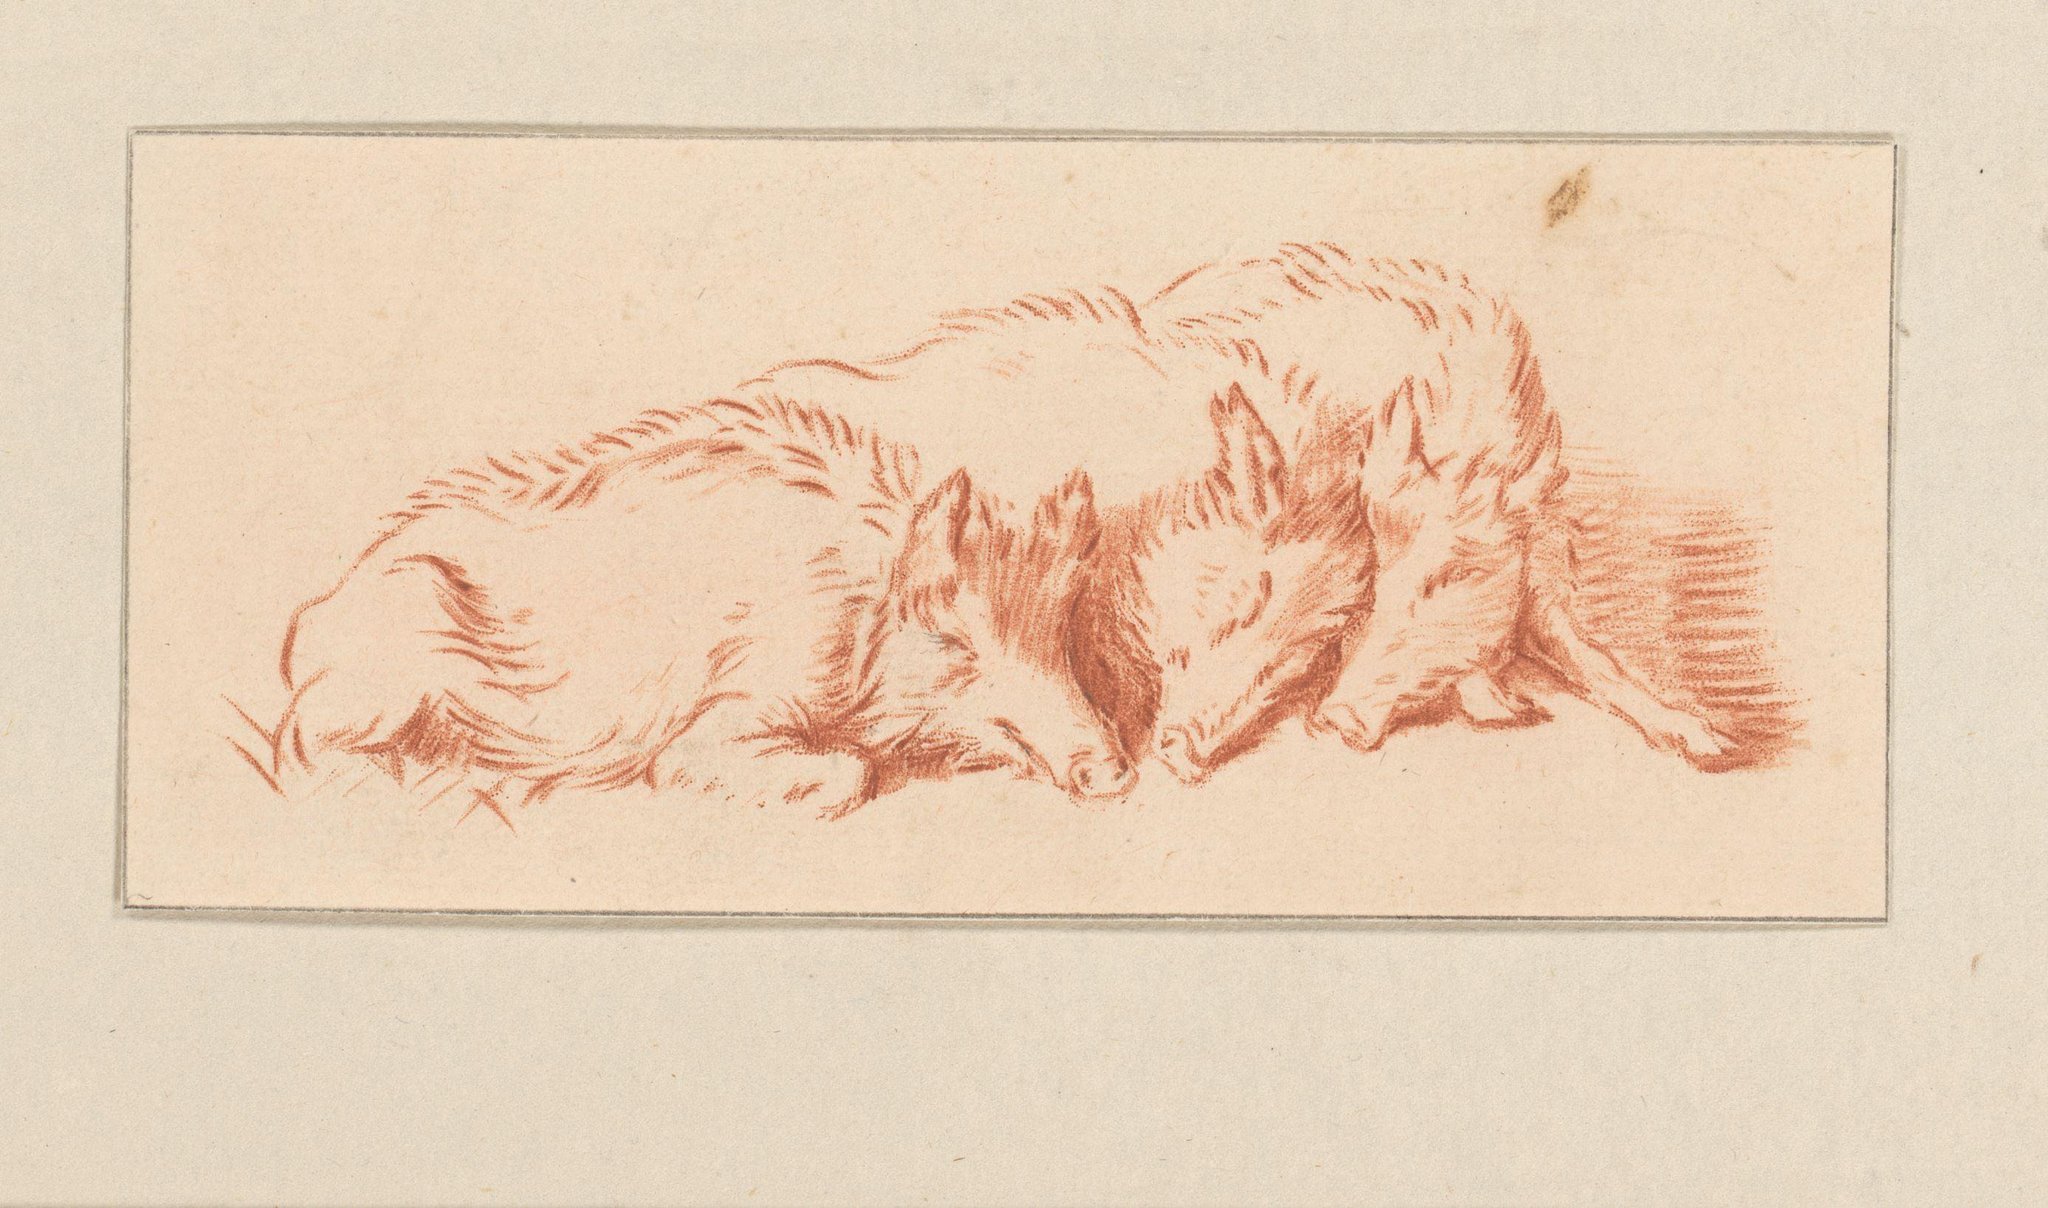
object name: print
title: Drie liggende zwijnen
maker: jurriaan cootwijck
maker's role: print maker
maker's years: 1714-1798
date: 1724-1798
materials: paper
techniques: printmaking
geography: amsterdam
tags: hoofed animals: boar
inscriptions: collector's mark: ‘RIJKS / MUSM’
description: De prent werd opgenomen in: Collection d'imitations de dessins d'après les principaux maîtres hollandais et flamands, Londen, C. Josi, 1821.